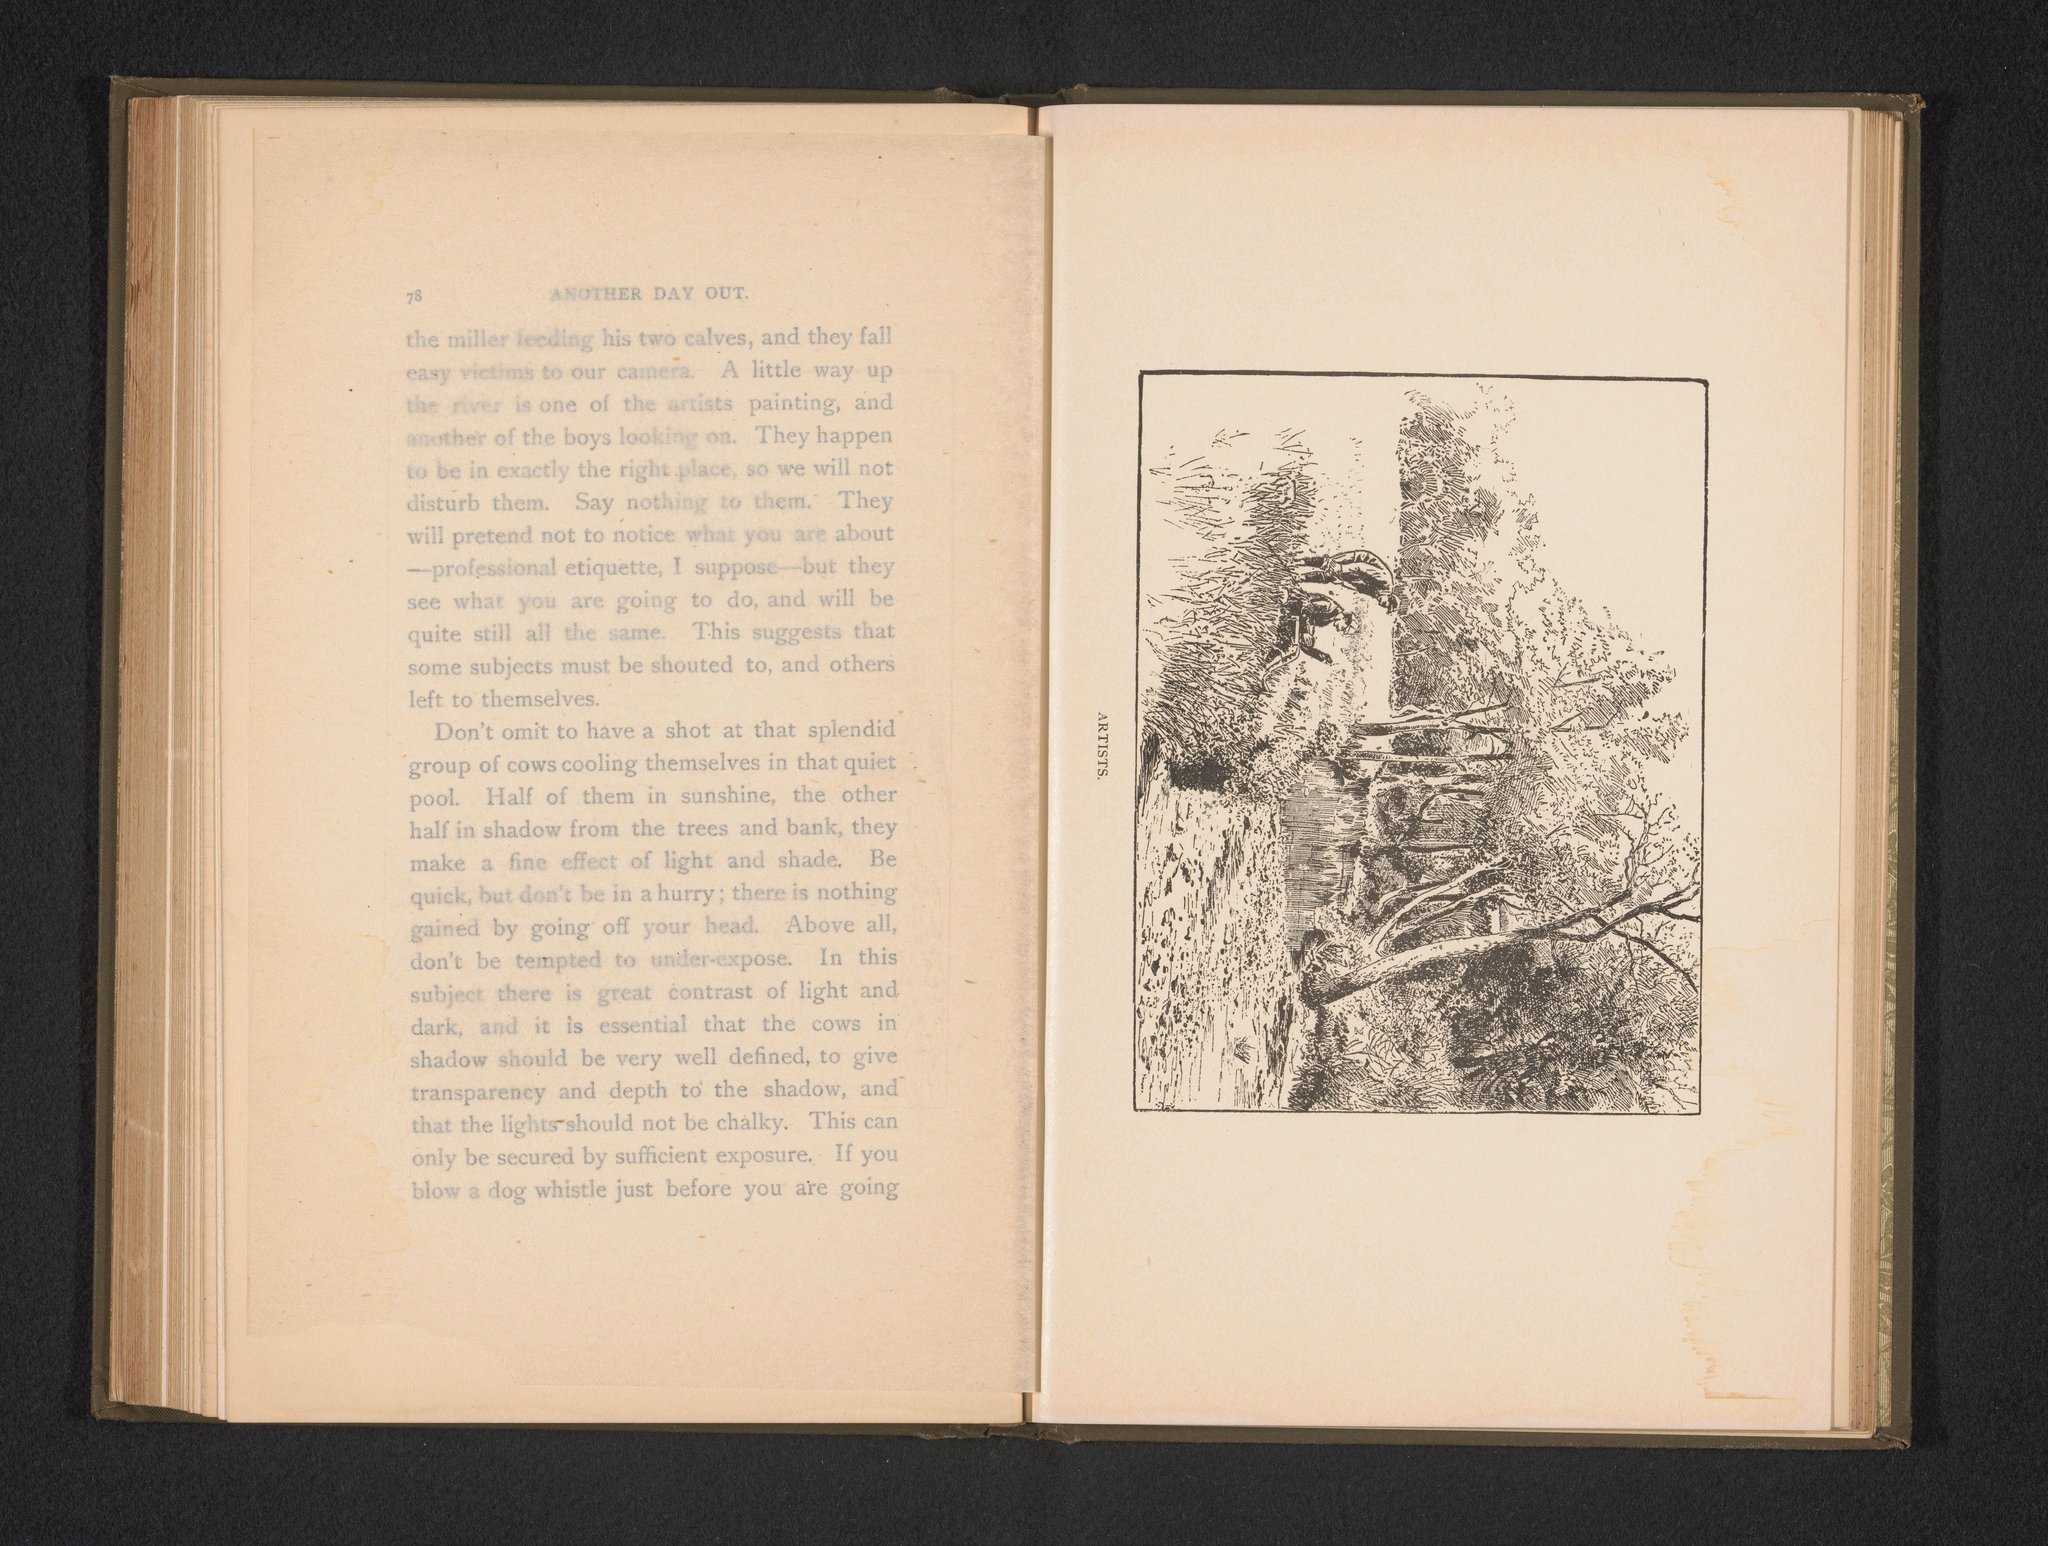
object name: photomechanical print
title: Fotoreproductie van een gezicht op twee onbekende personen in een landschap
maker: Anonymous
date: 1883-1888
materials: paper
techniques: autotype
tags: landscapes, historical persons (portraits and scenes from the life)